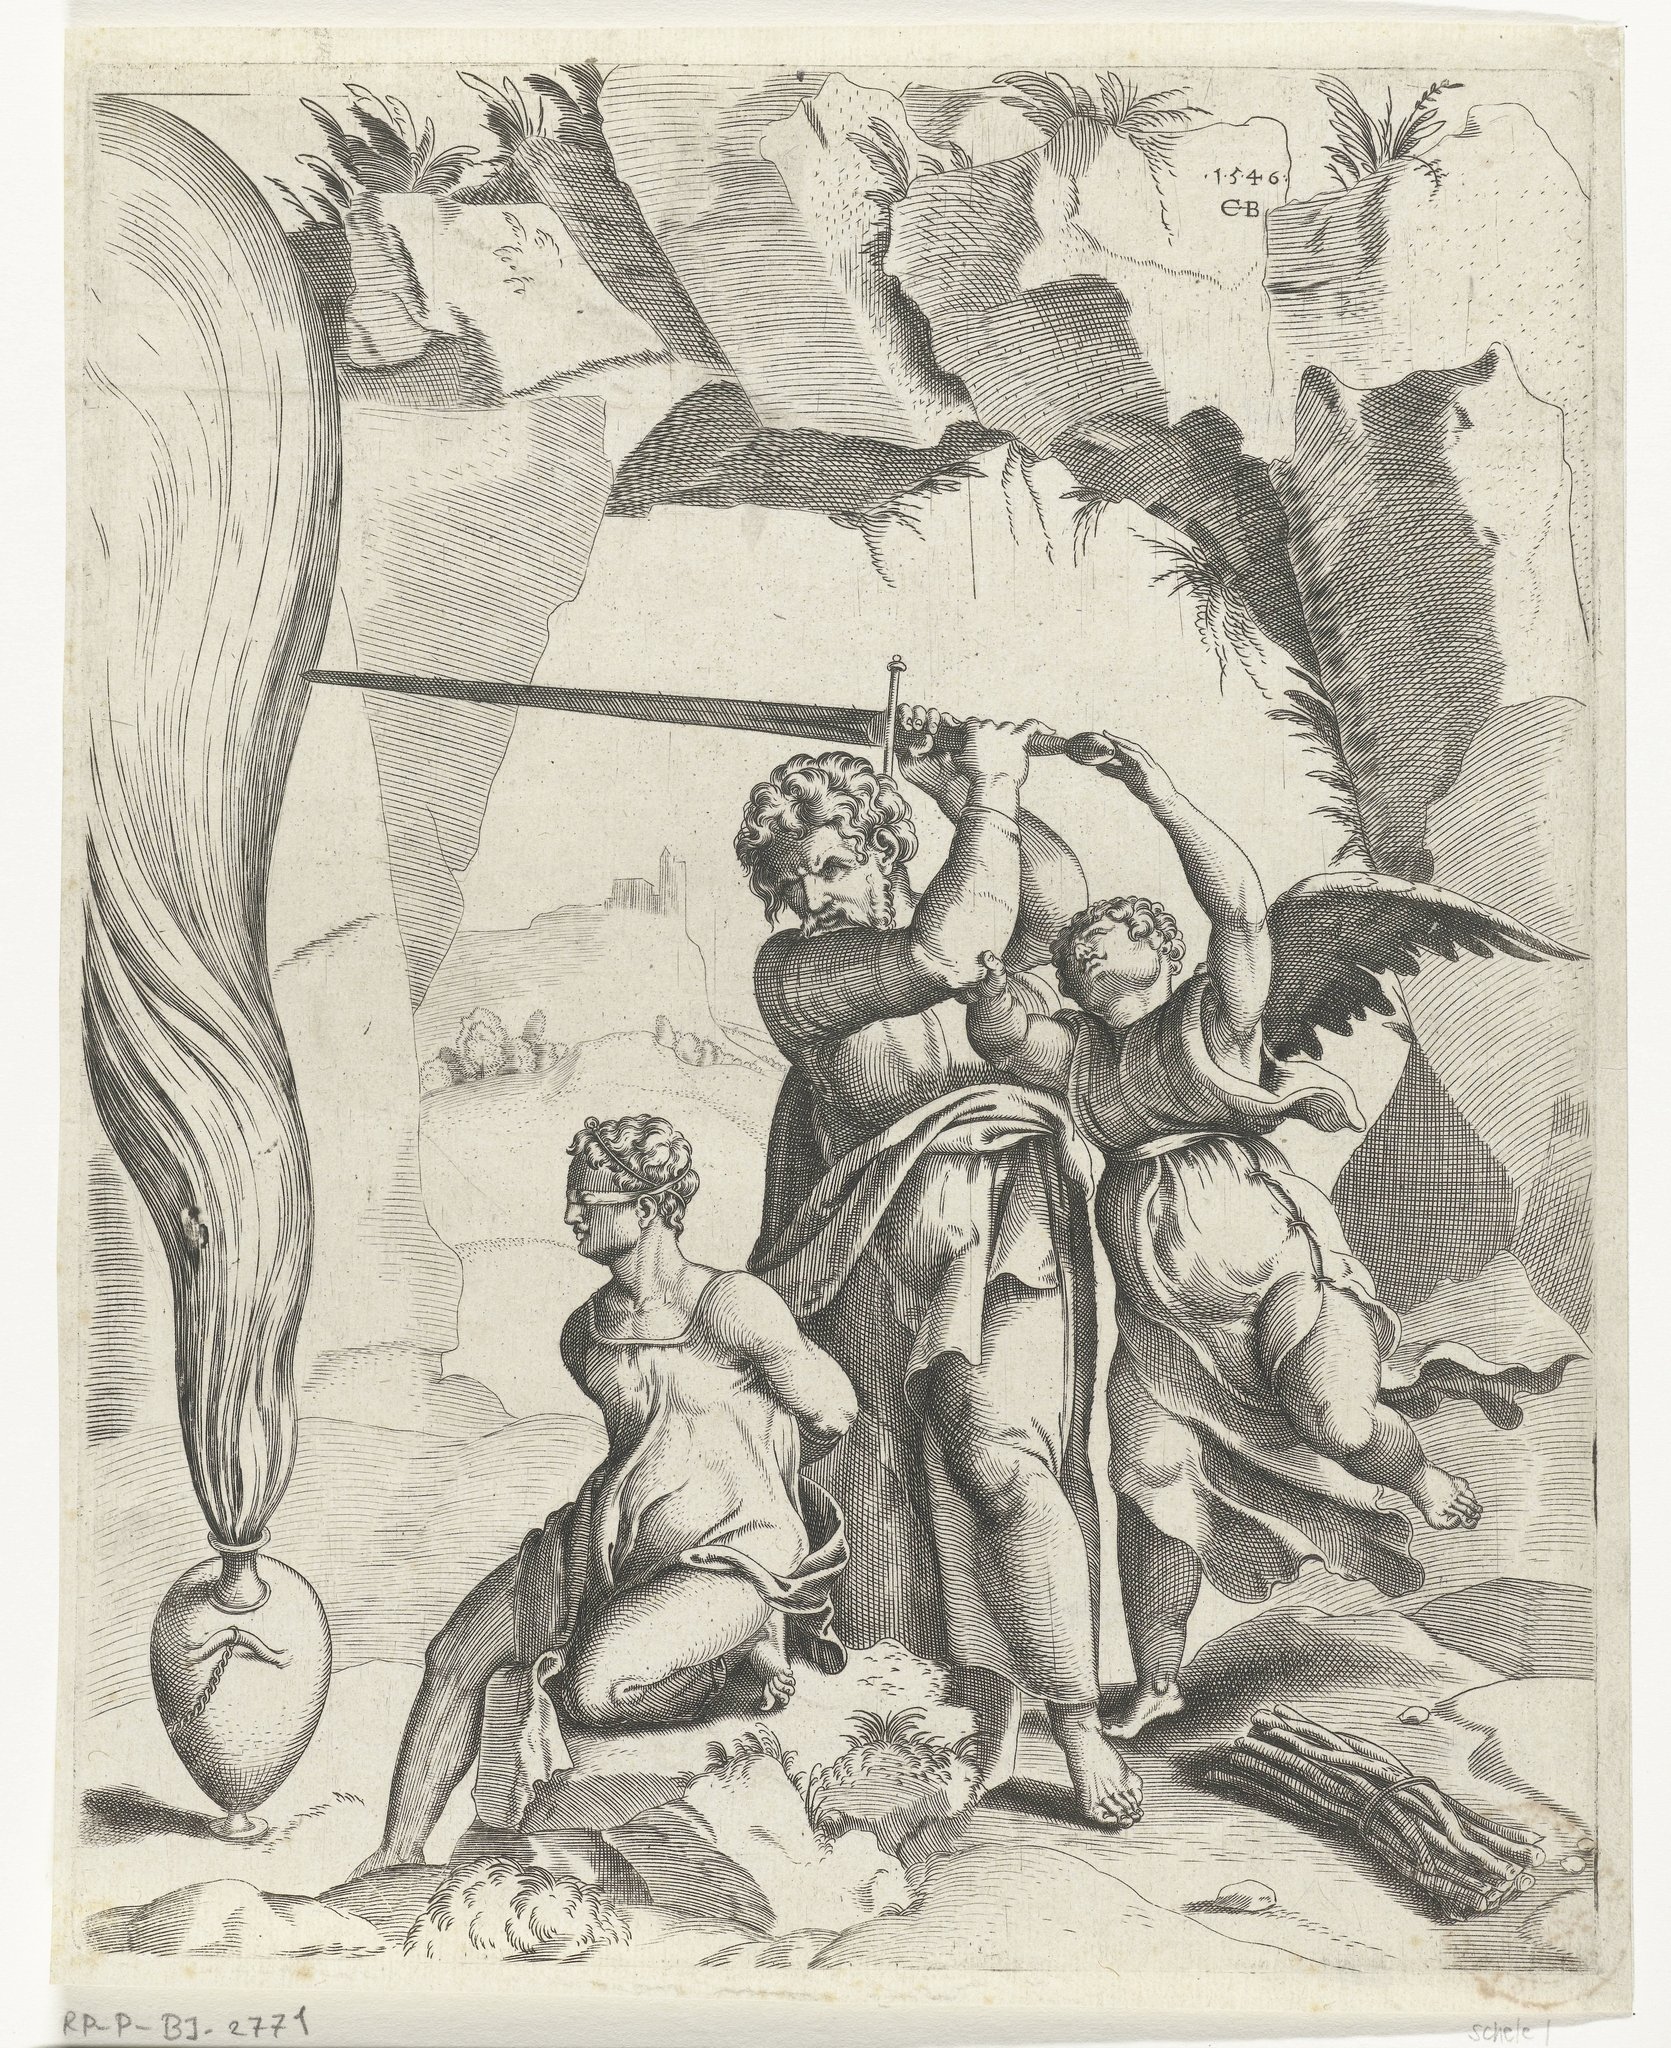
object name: print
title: Offer van Isaak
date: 1546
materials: paper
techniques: engraving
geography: nuremberg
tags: the sacrifice of isaac (genesis 22)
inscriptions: collector's mark: Lugt 240, collector's mark: Lugt 2228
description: Abraham staat op het punt om zijn geliefde zoon Isaak te offeren. Een engel houdt hem tegen. In tegenstelling tot de beeldtraditie speelt zich de scène in een soort grot af in plaats van op een berg.